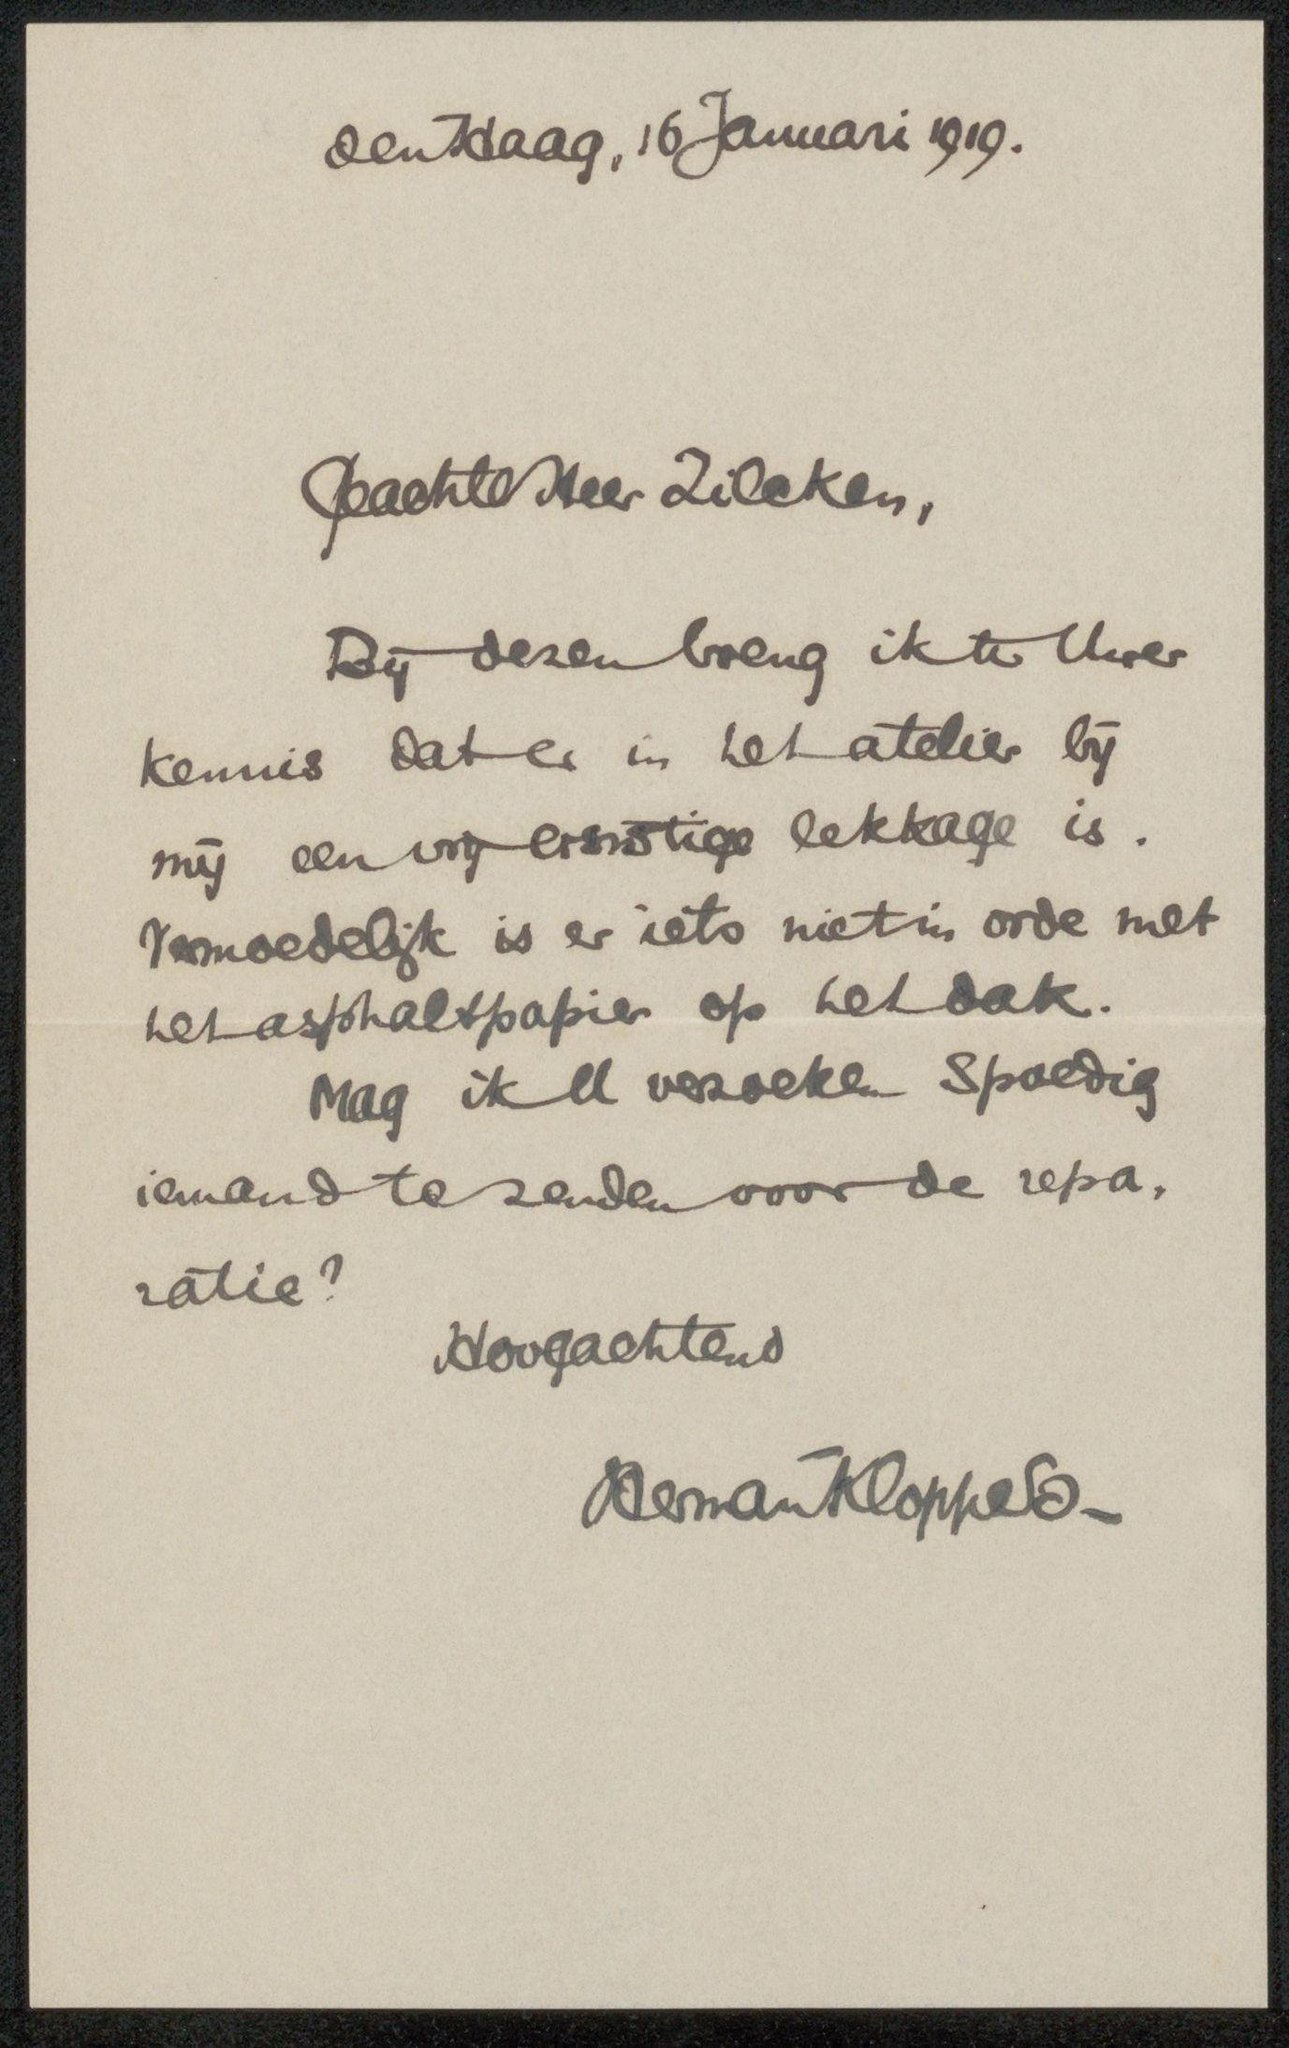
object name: letter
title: Brief aan Philip Zilcken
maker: herman kloppers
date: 1919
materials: ink, paper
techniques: pen, writing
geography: the hague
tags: painter, draughtsman, philip zilcken, workshop, studio of the artist (in general)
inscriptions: collector's mark: ‘RPK’